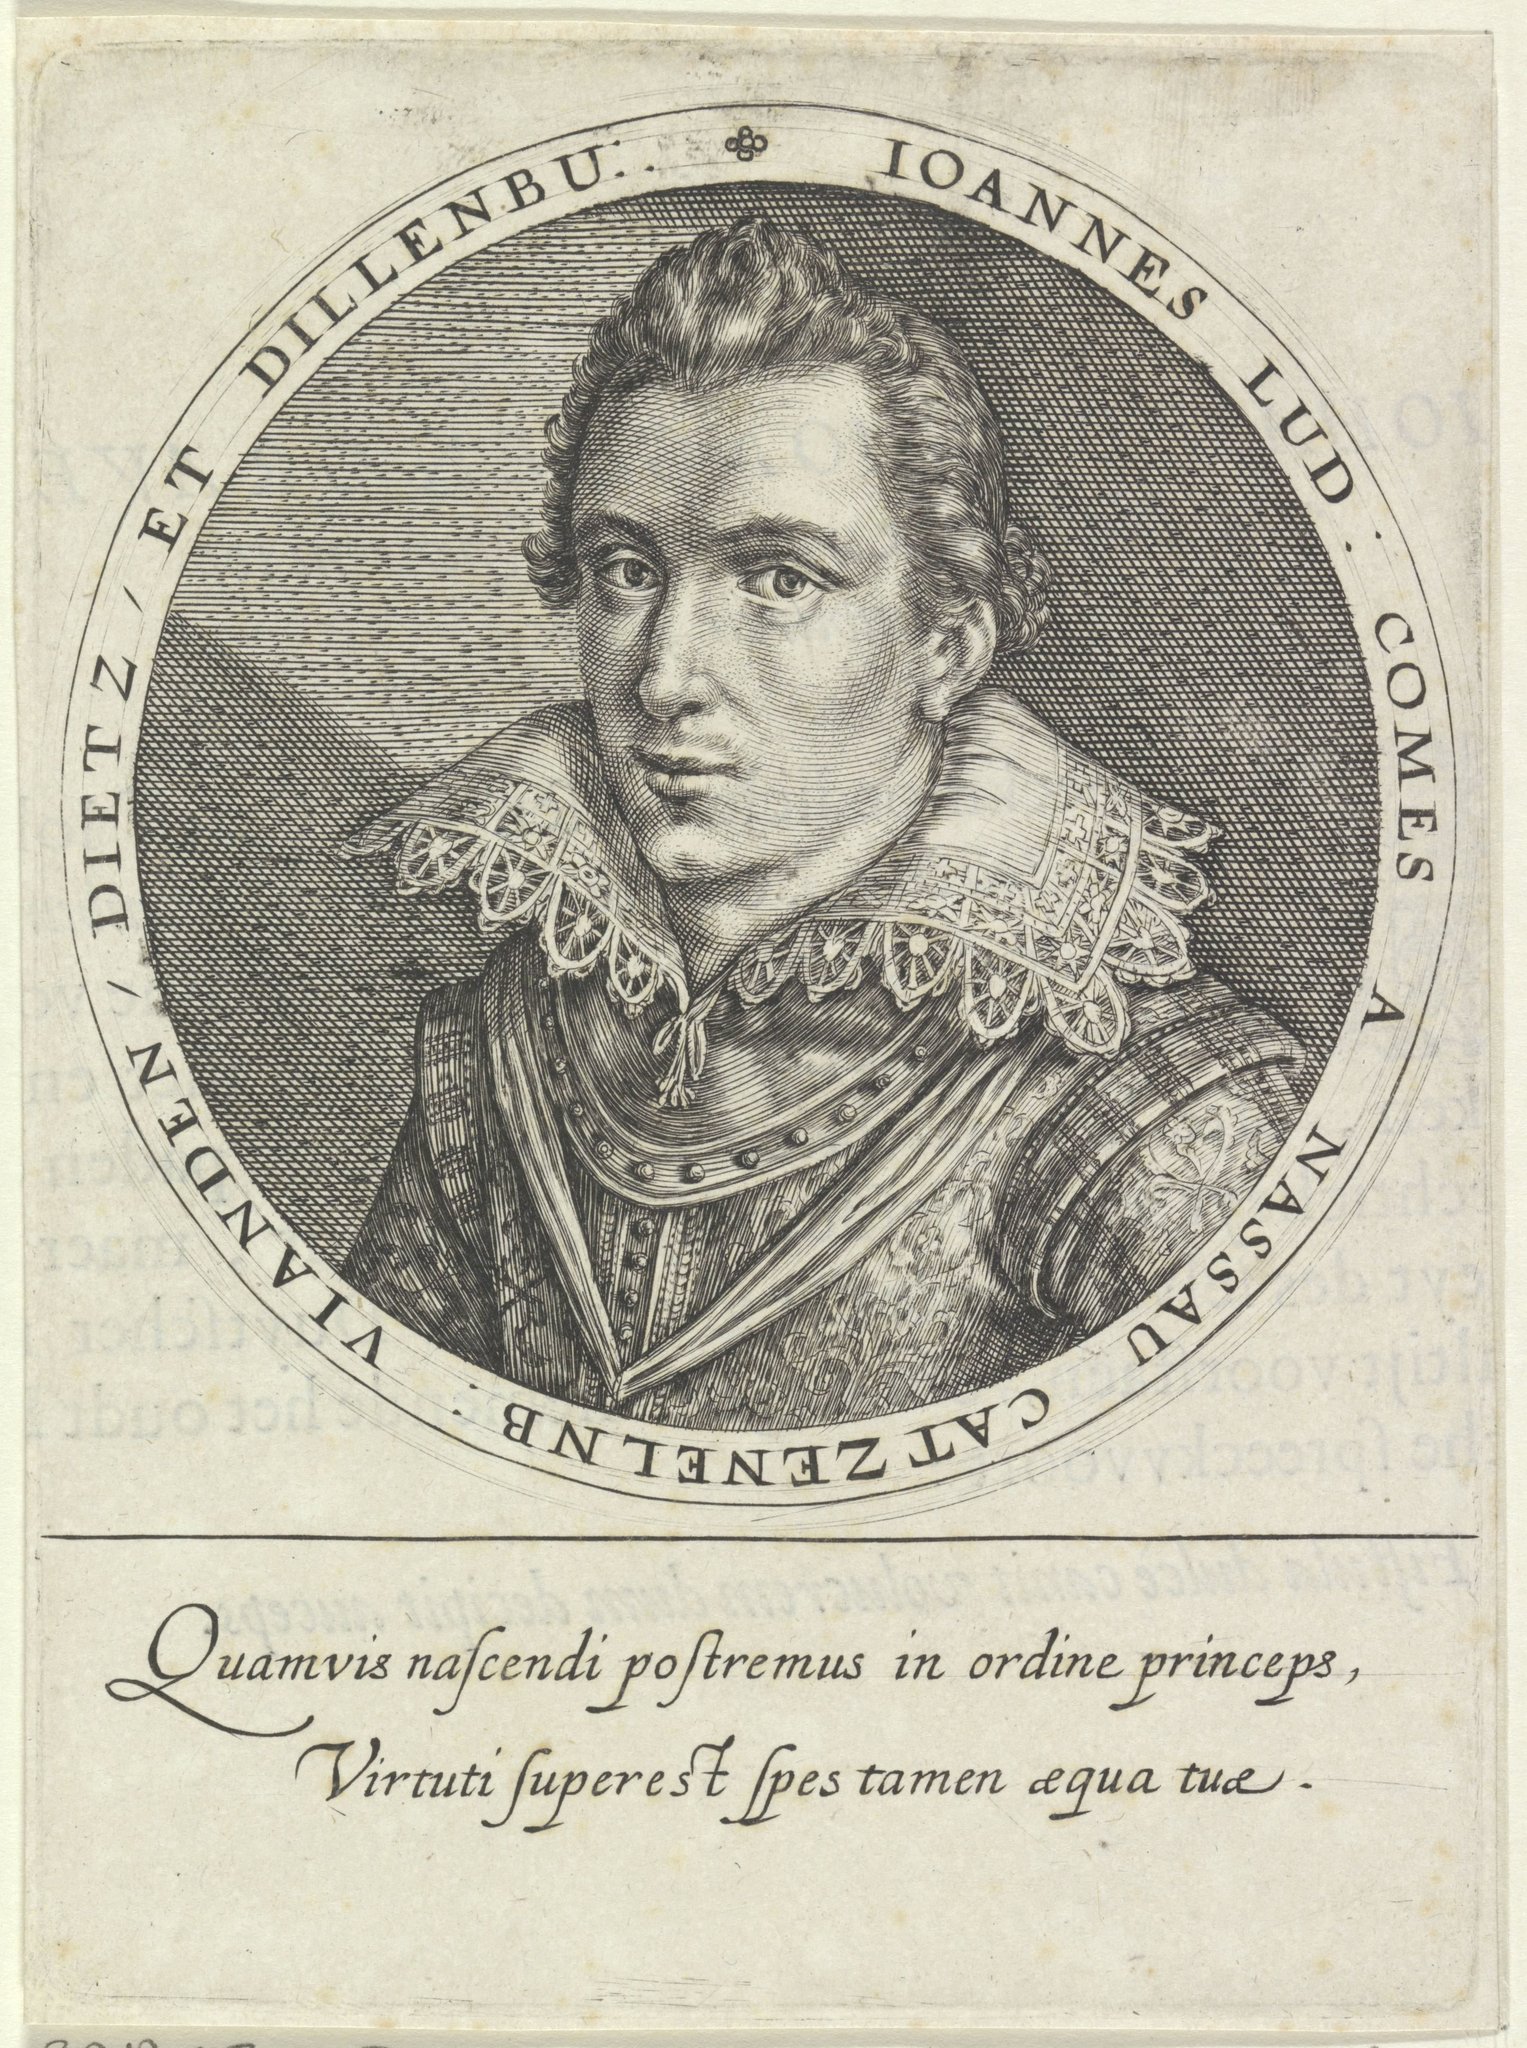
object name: print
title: Portret van Johan Lodewijk, graaf van Nassau-Hadamar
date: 1615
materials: paper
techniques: engraving, etching, letterpress printing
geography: utrecht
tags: johan lodewijk graaf van nassau-hadamar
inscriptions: collector's mark: Lugt 963, collector's mark: Lugt 2228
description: De hier vermelde titel verwijst naar de hoogst verkregen titel van de geportretteerde, niet per se naar de titel die de geportretteerde op deze voorstelling draagt. Prent uit: Buchelius, Arnoldus. Nassovischen Oraignen-boom, daer by ghevoecht, de conterfeytsels der voornaemster helden. = Malus Aurantius Nassovicus. Utrecht: Salomon de Roy, 1615.